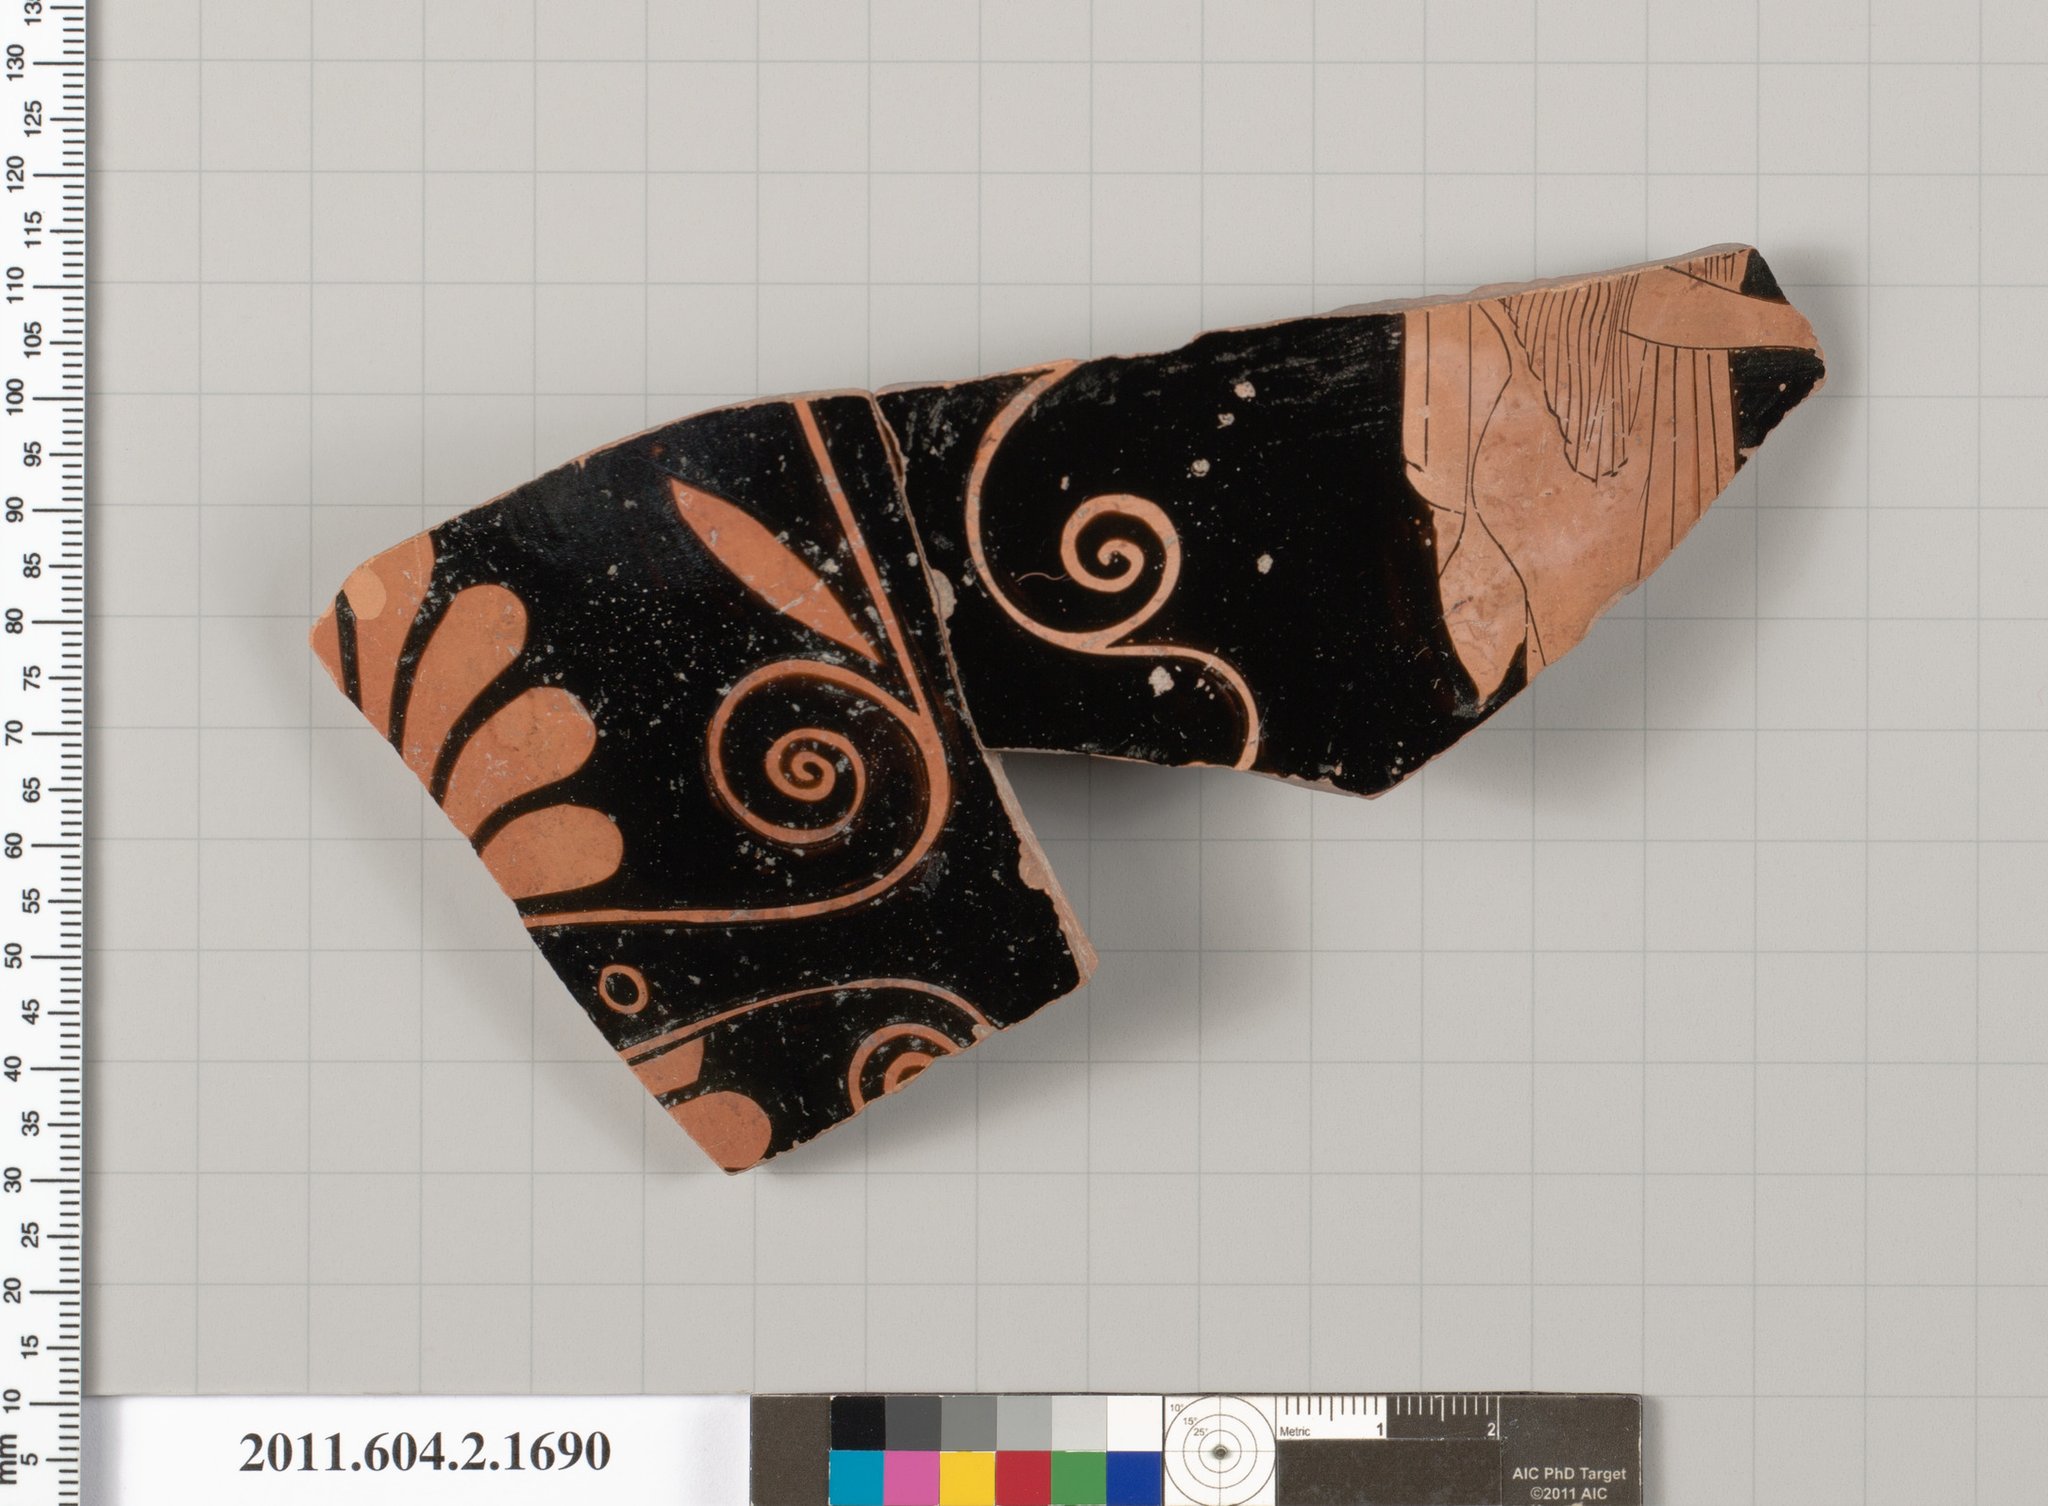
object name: skyphos fragment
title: Terracotta fragment of a skyphos (deep drinking cup)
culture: greek, attic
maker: lewis painter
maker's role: artist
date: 480-470 BCE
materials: terracotta